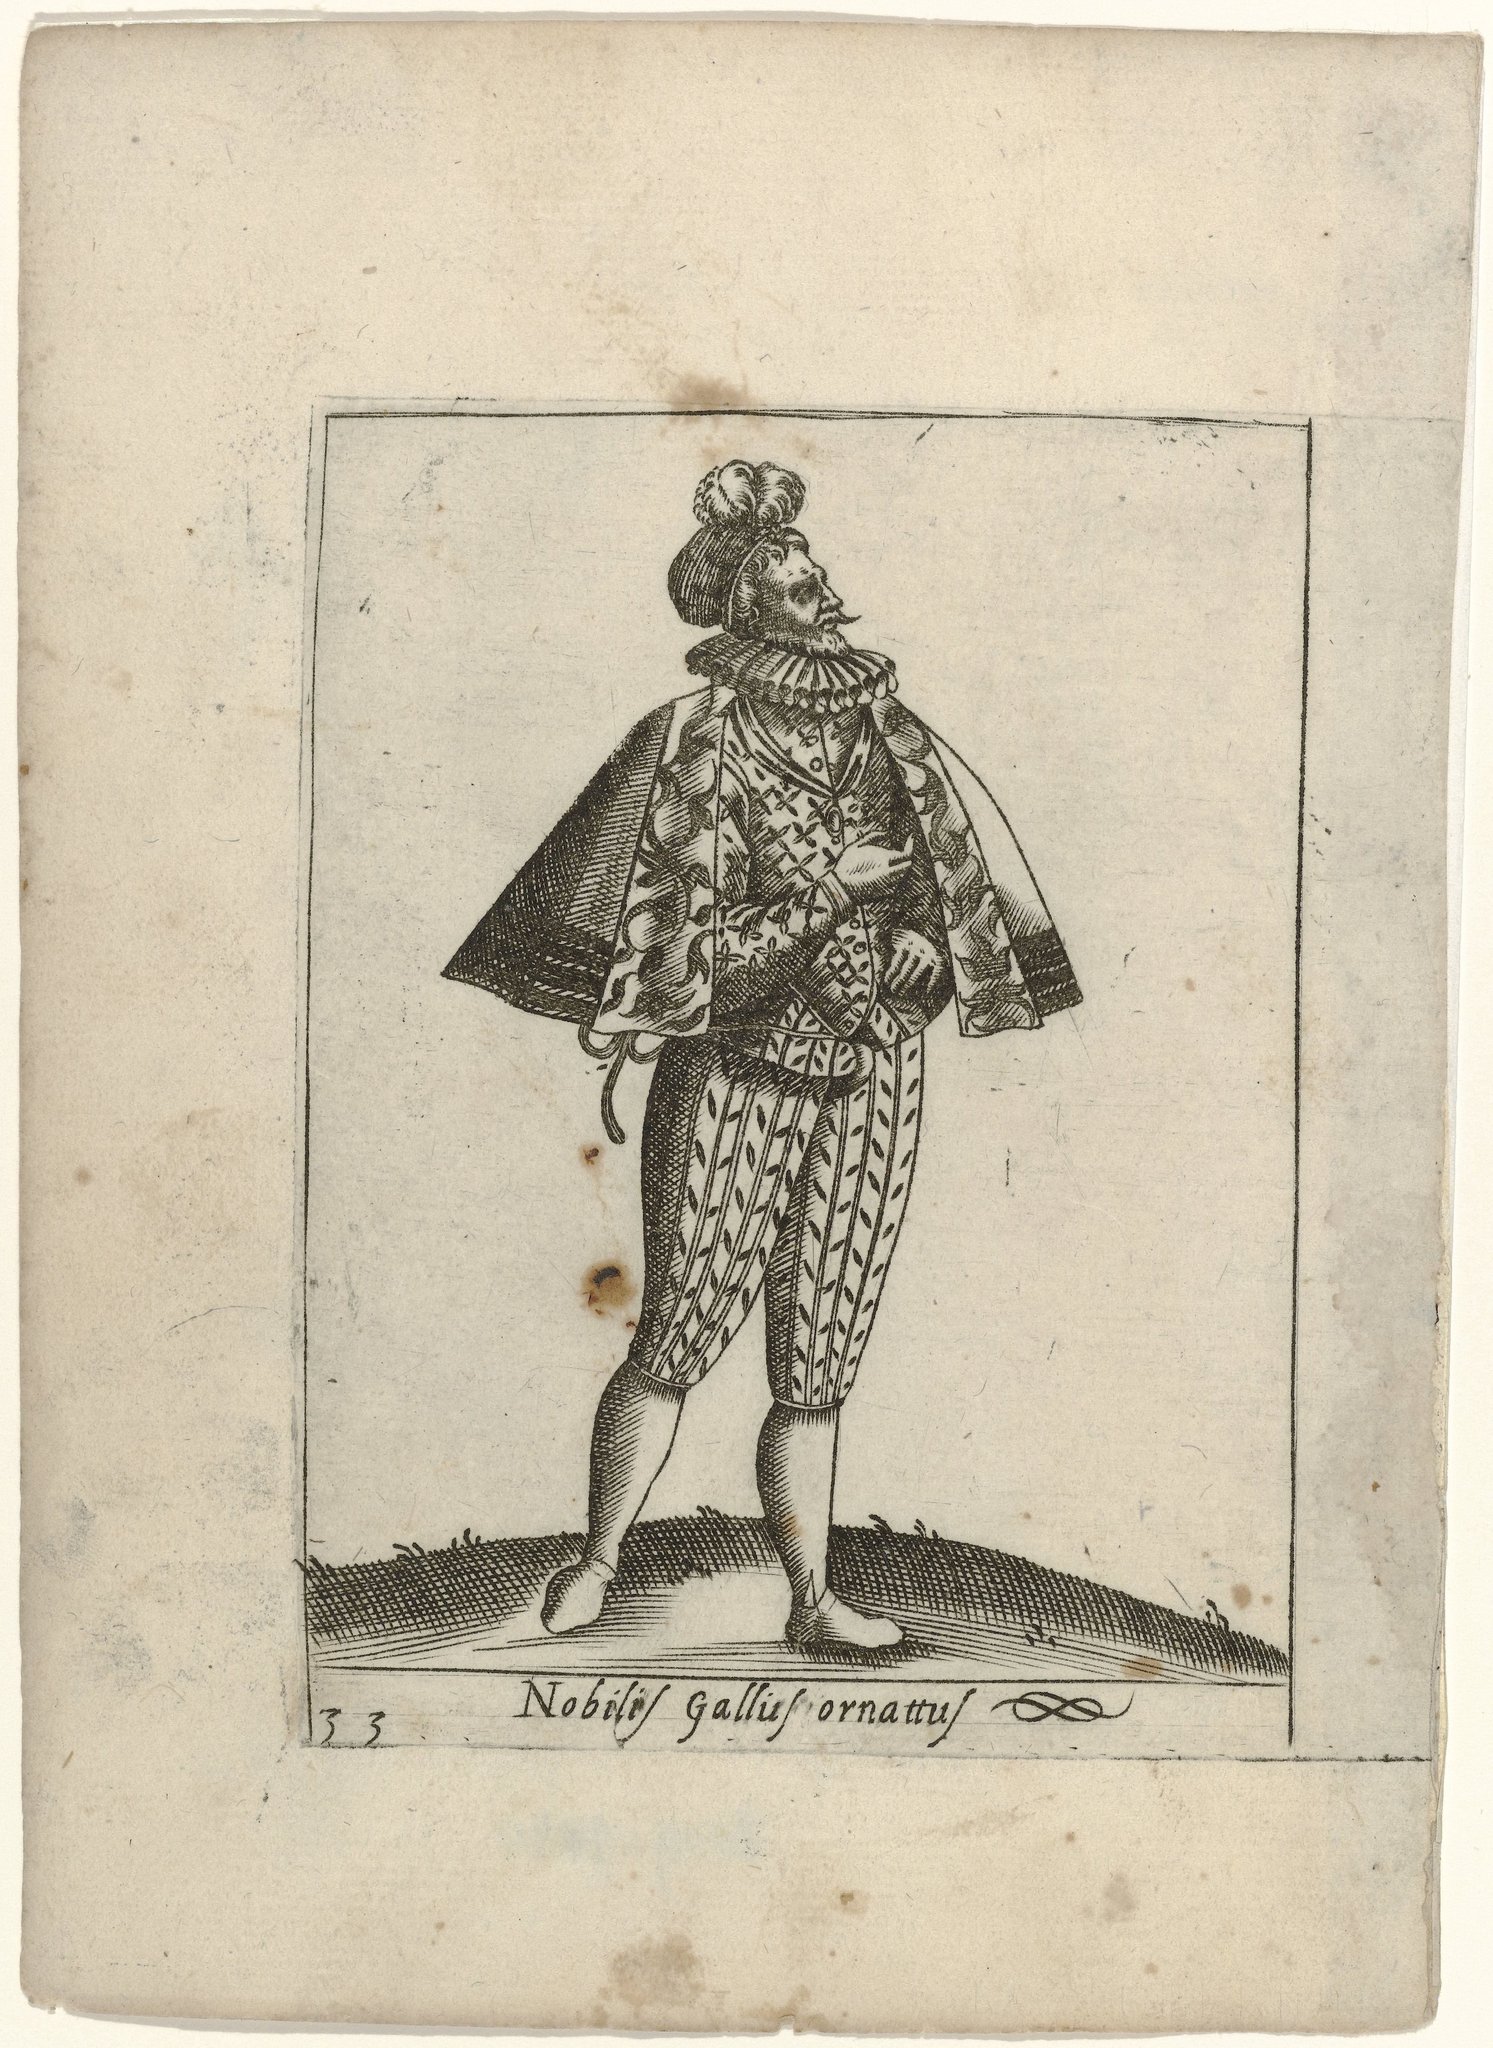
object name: print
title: Diversarum Nationum habitus (...)Padua, 1592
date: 1592-1594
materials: paper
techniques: engraving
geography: italy